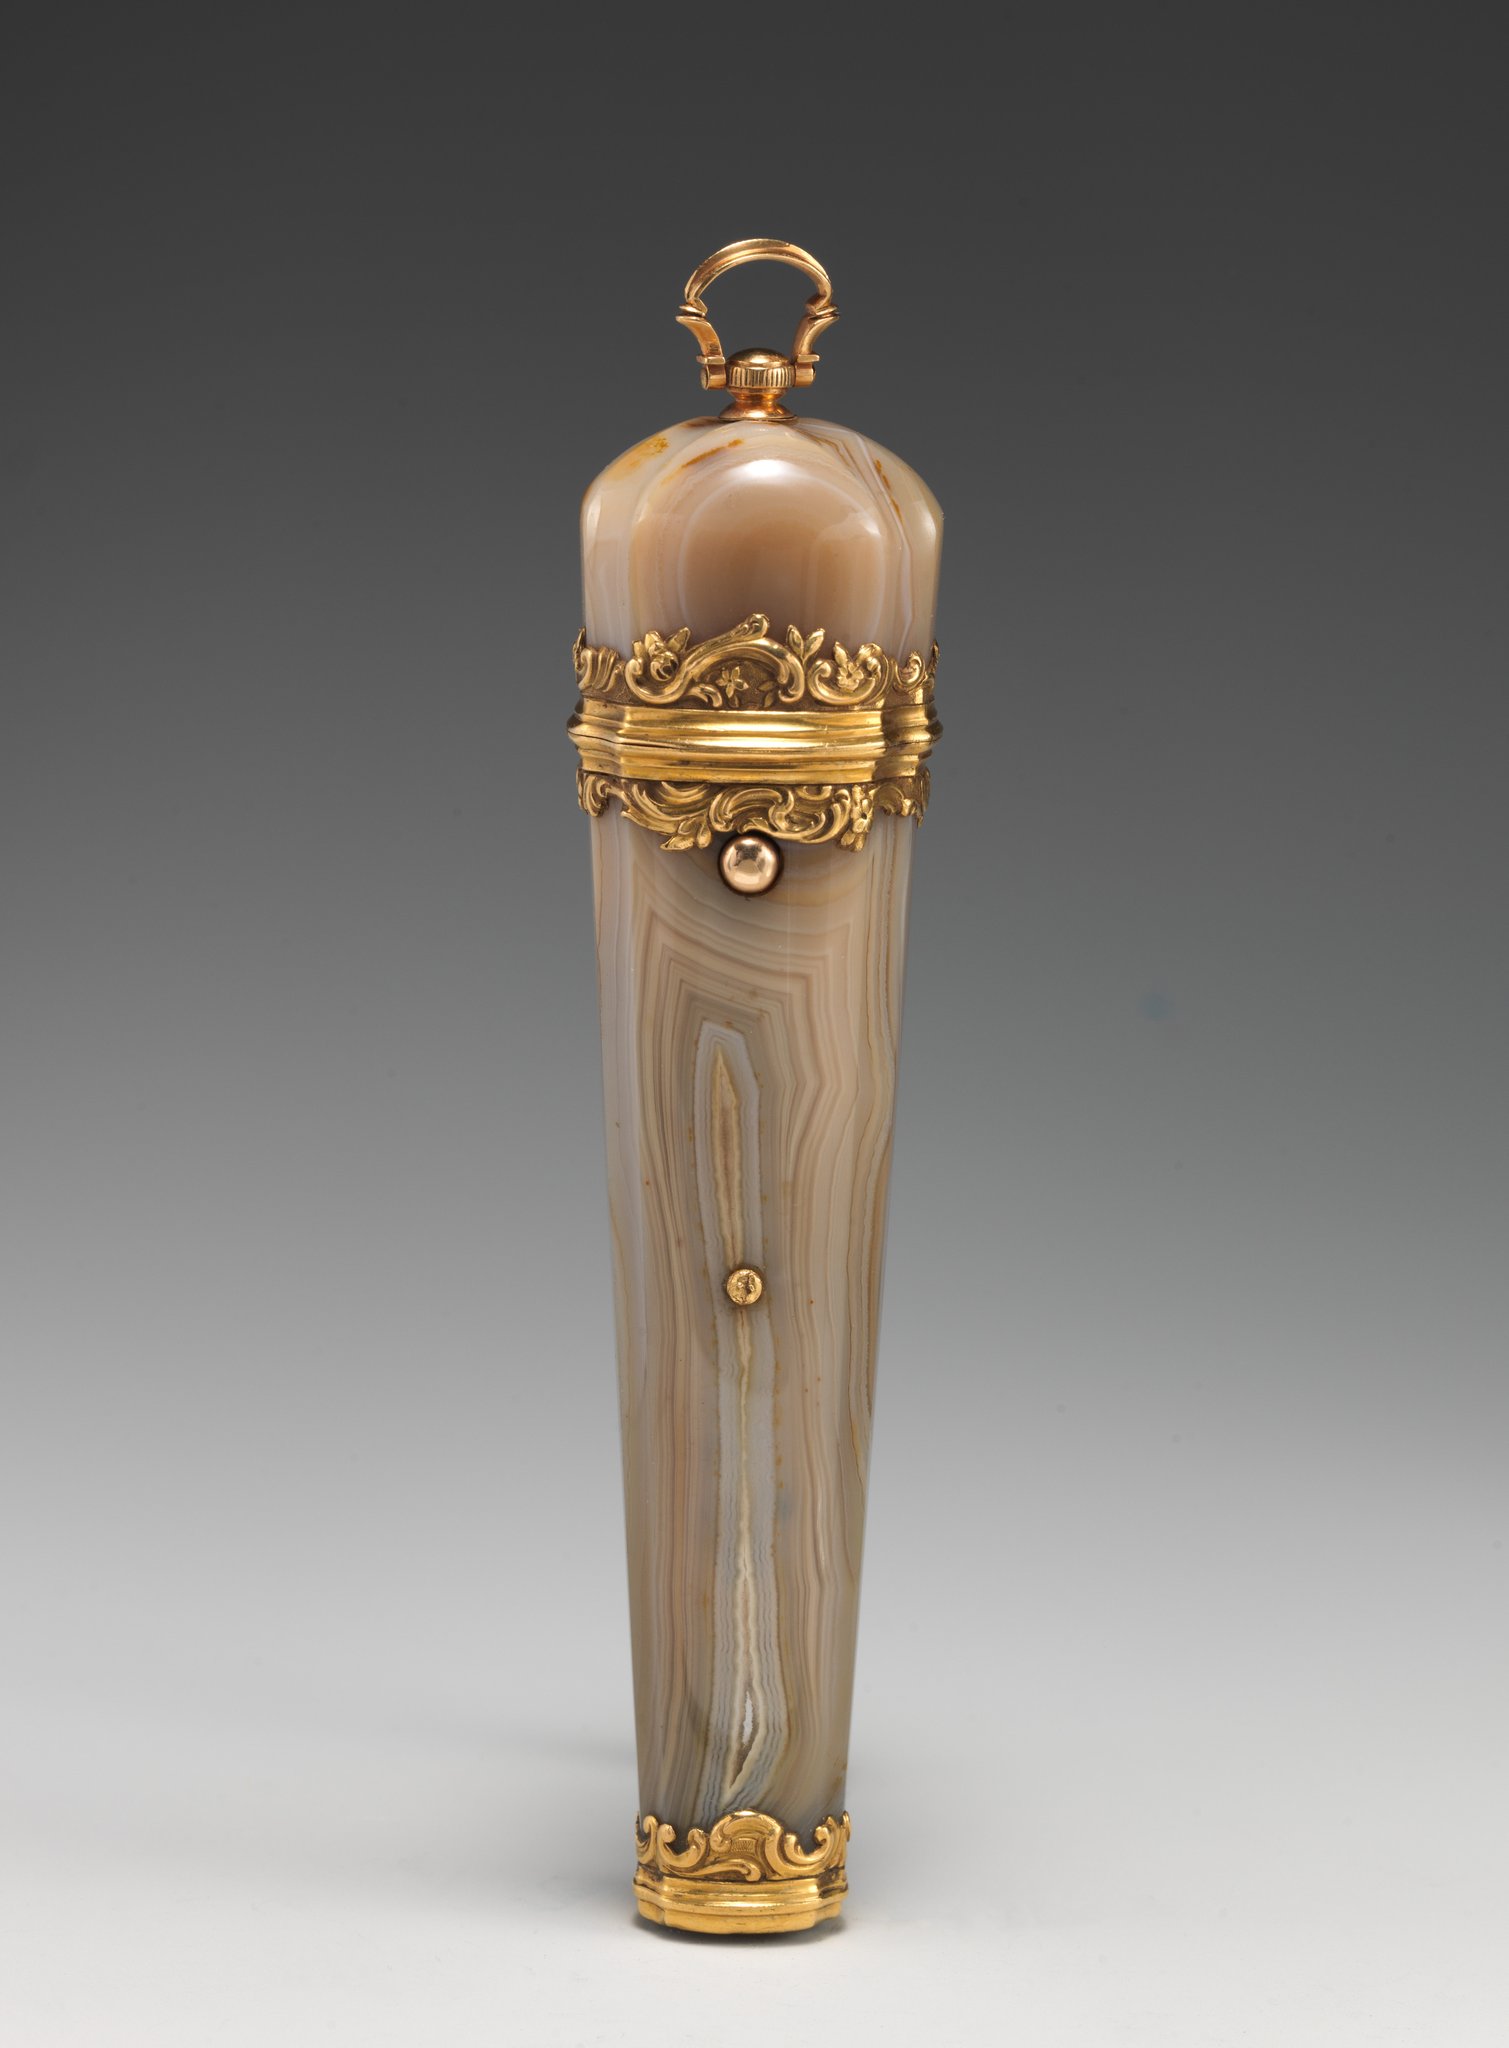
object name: étui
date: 1734-1766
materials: stone, gold